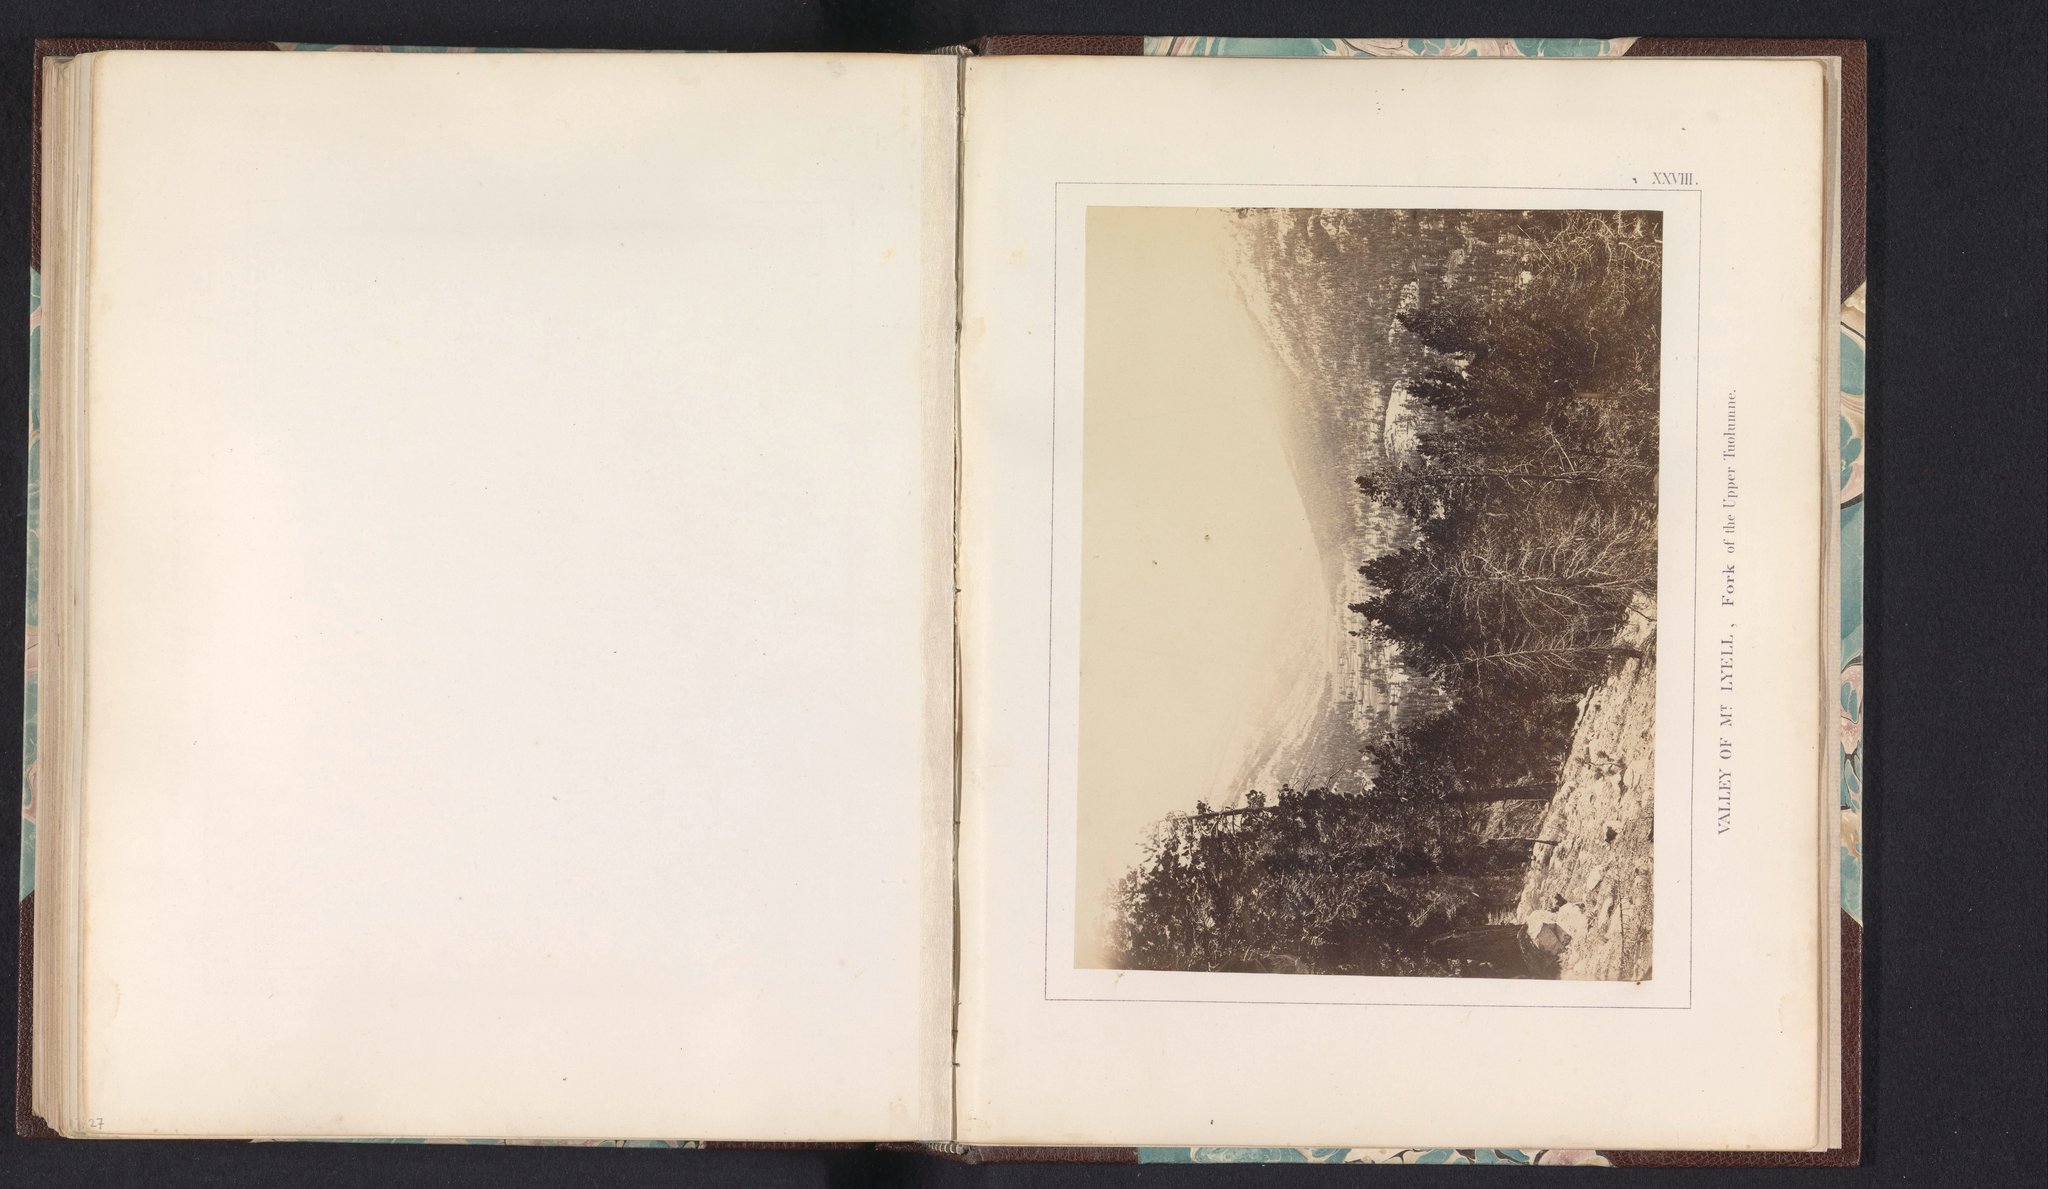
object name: photograph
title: Gezicht op een vallei aan de voet van Mount Lyell in Californië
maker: w. harris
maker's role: fotograaf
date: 1860-1868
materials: photographic support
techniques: albumen print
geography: california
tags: dale, valley, river, mountains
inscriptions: number: ‘XXVIII.’